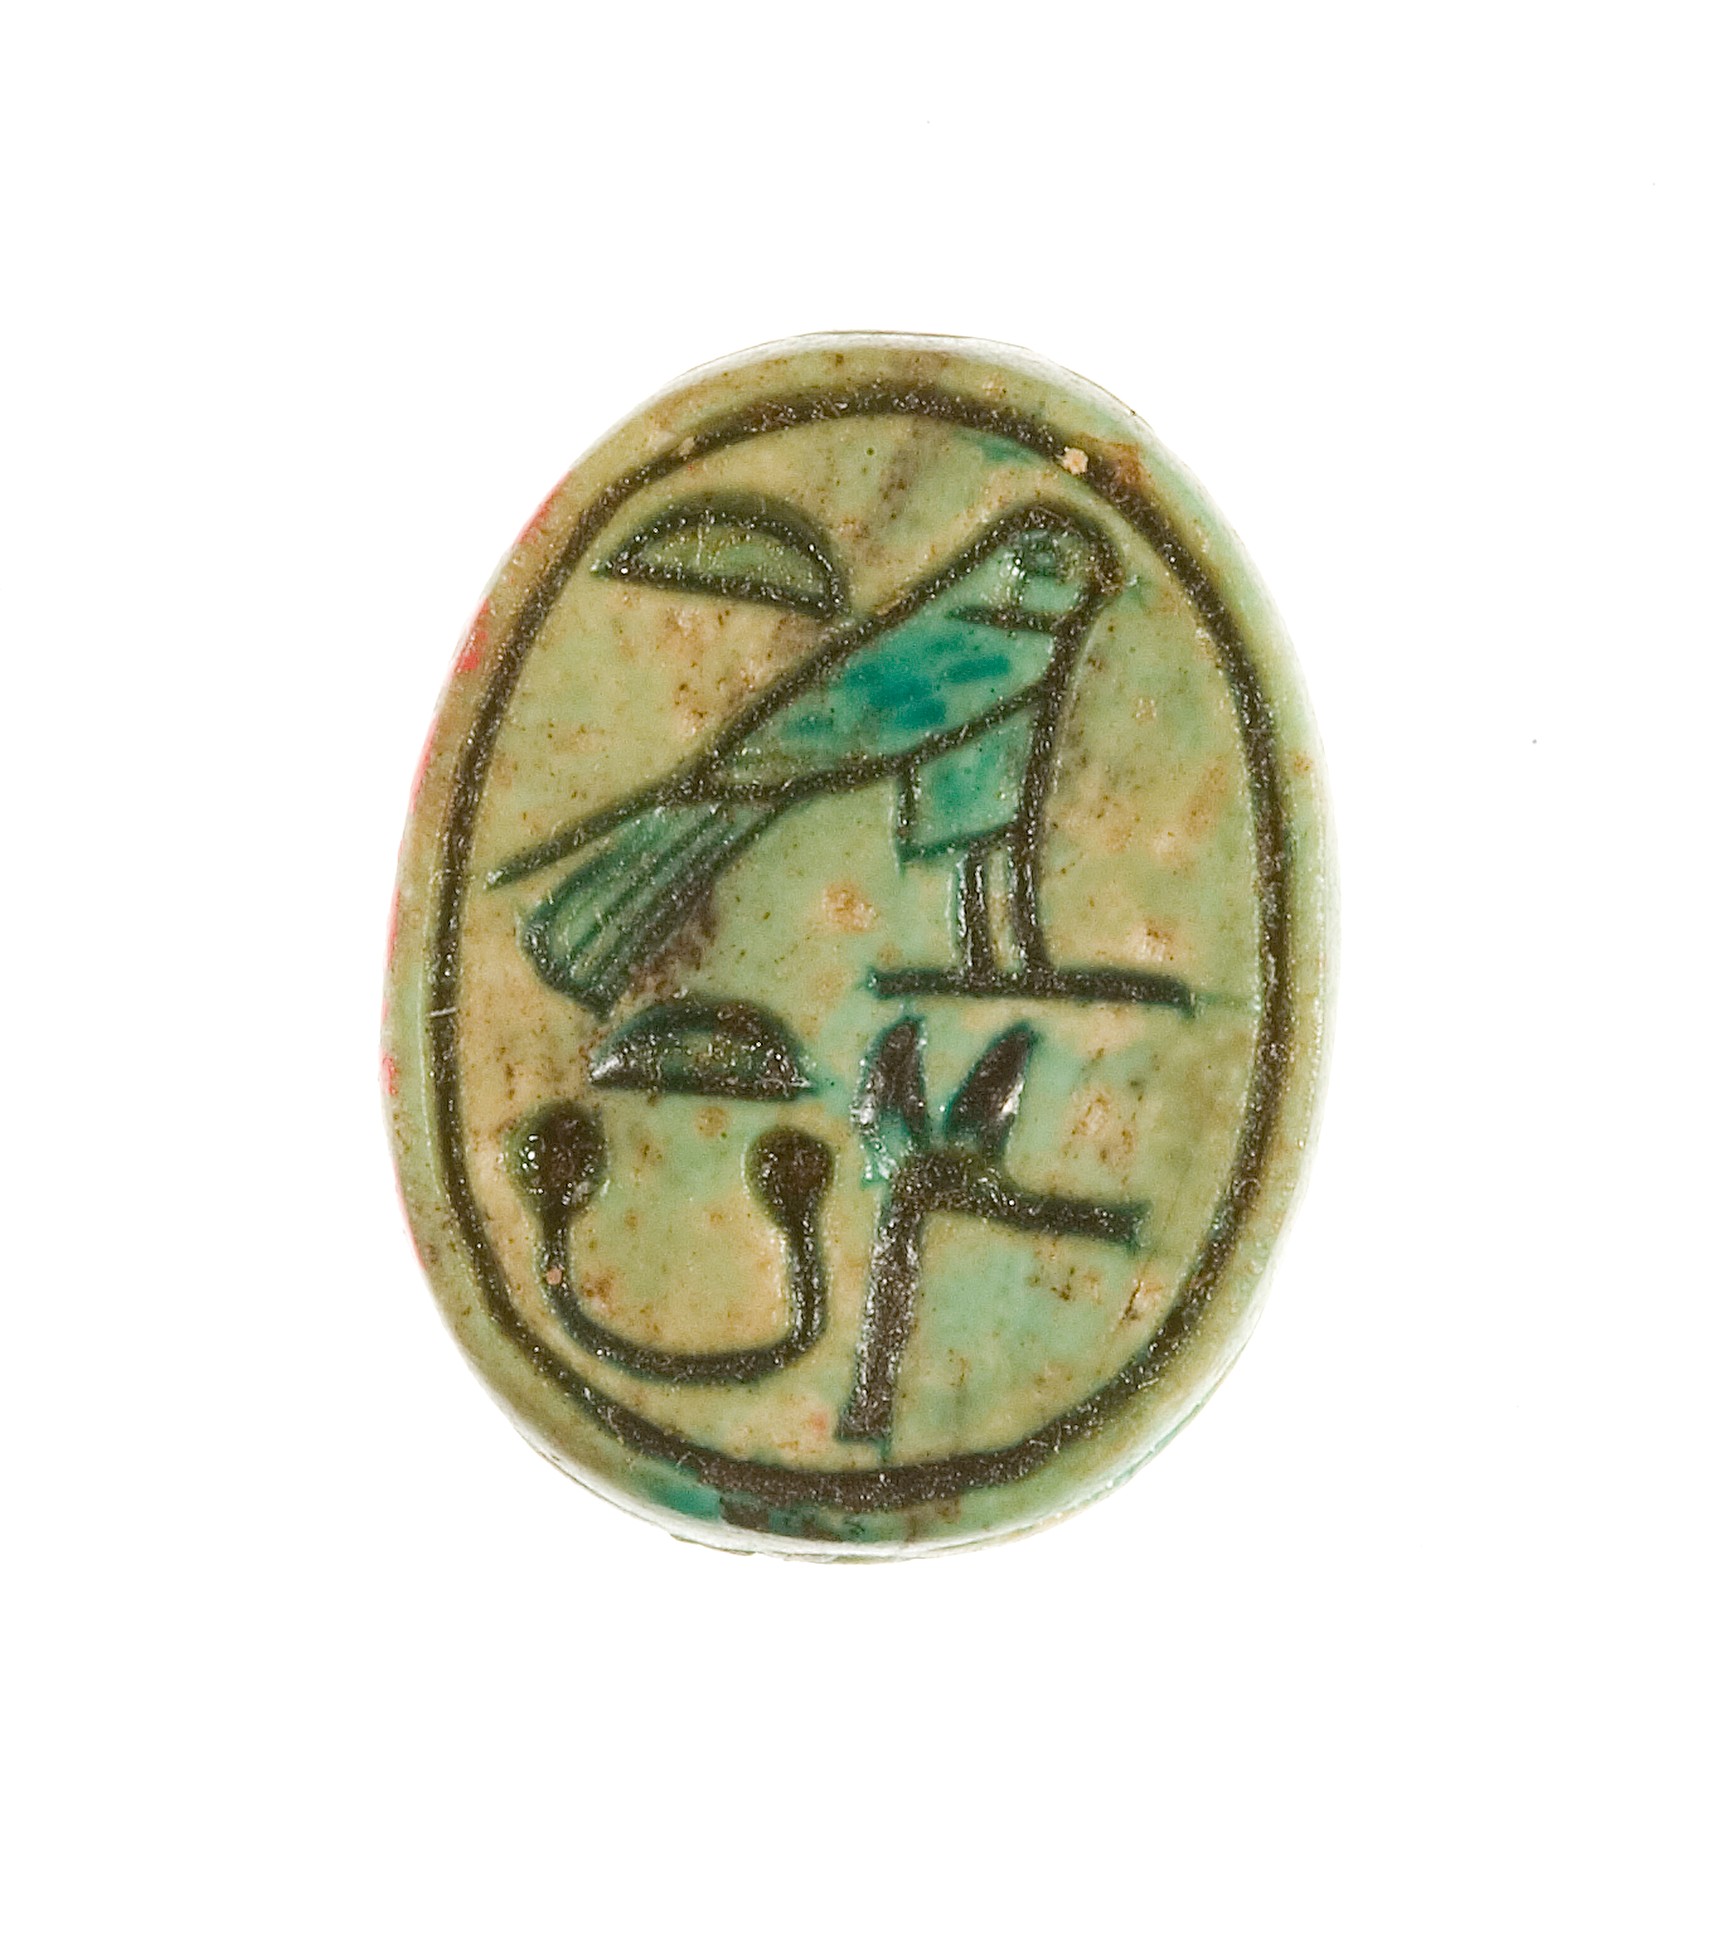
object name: scarab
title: Scarab Inscribed for the Female Horus Wosretkau (Hatshepsut)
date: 1479-1458 BCE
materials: stone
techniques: glazing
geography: egypt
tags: horus,scarabs